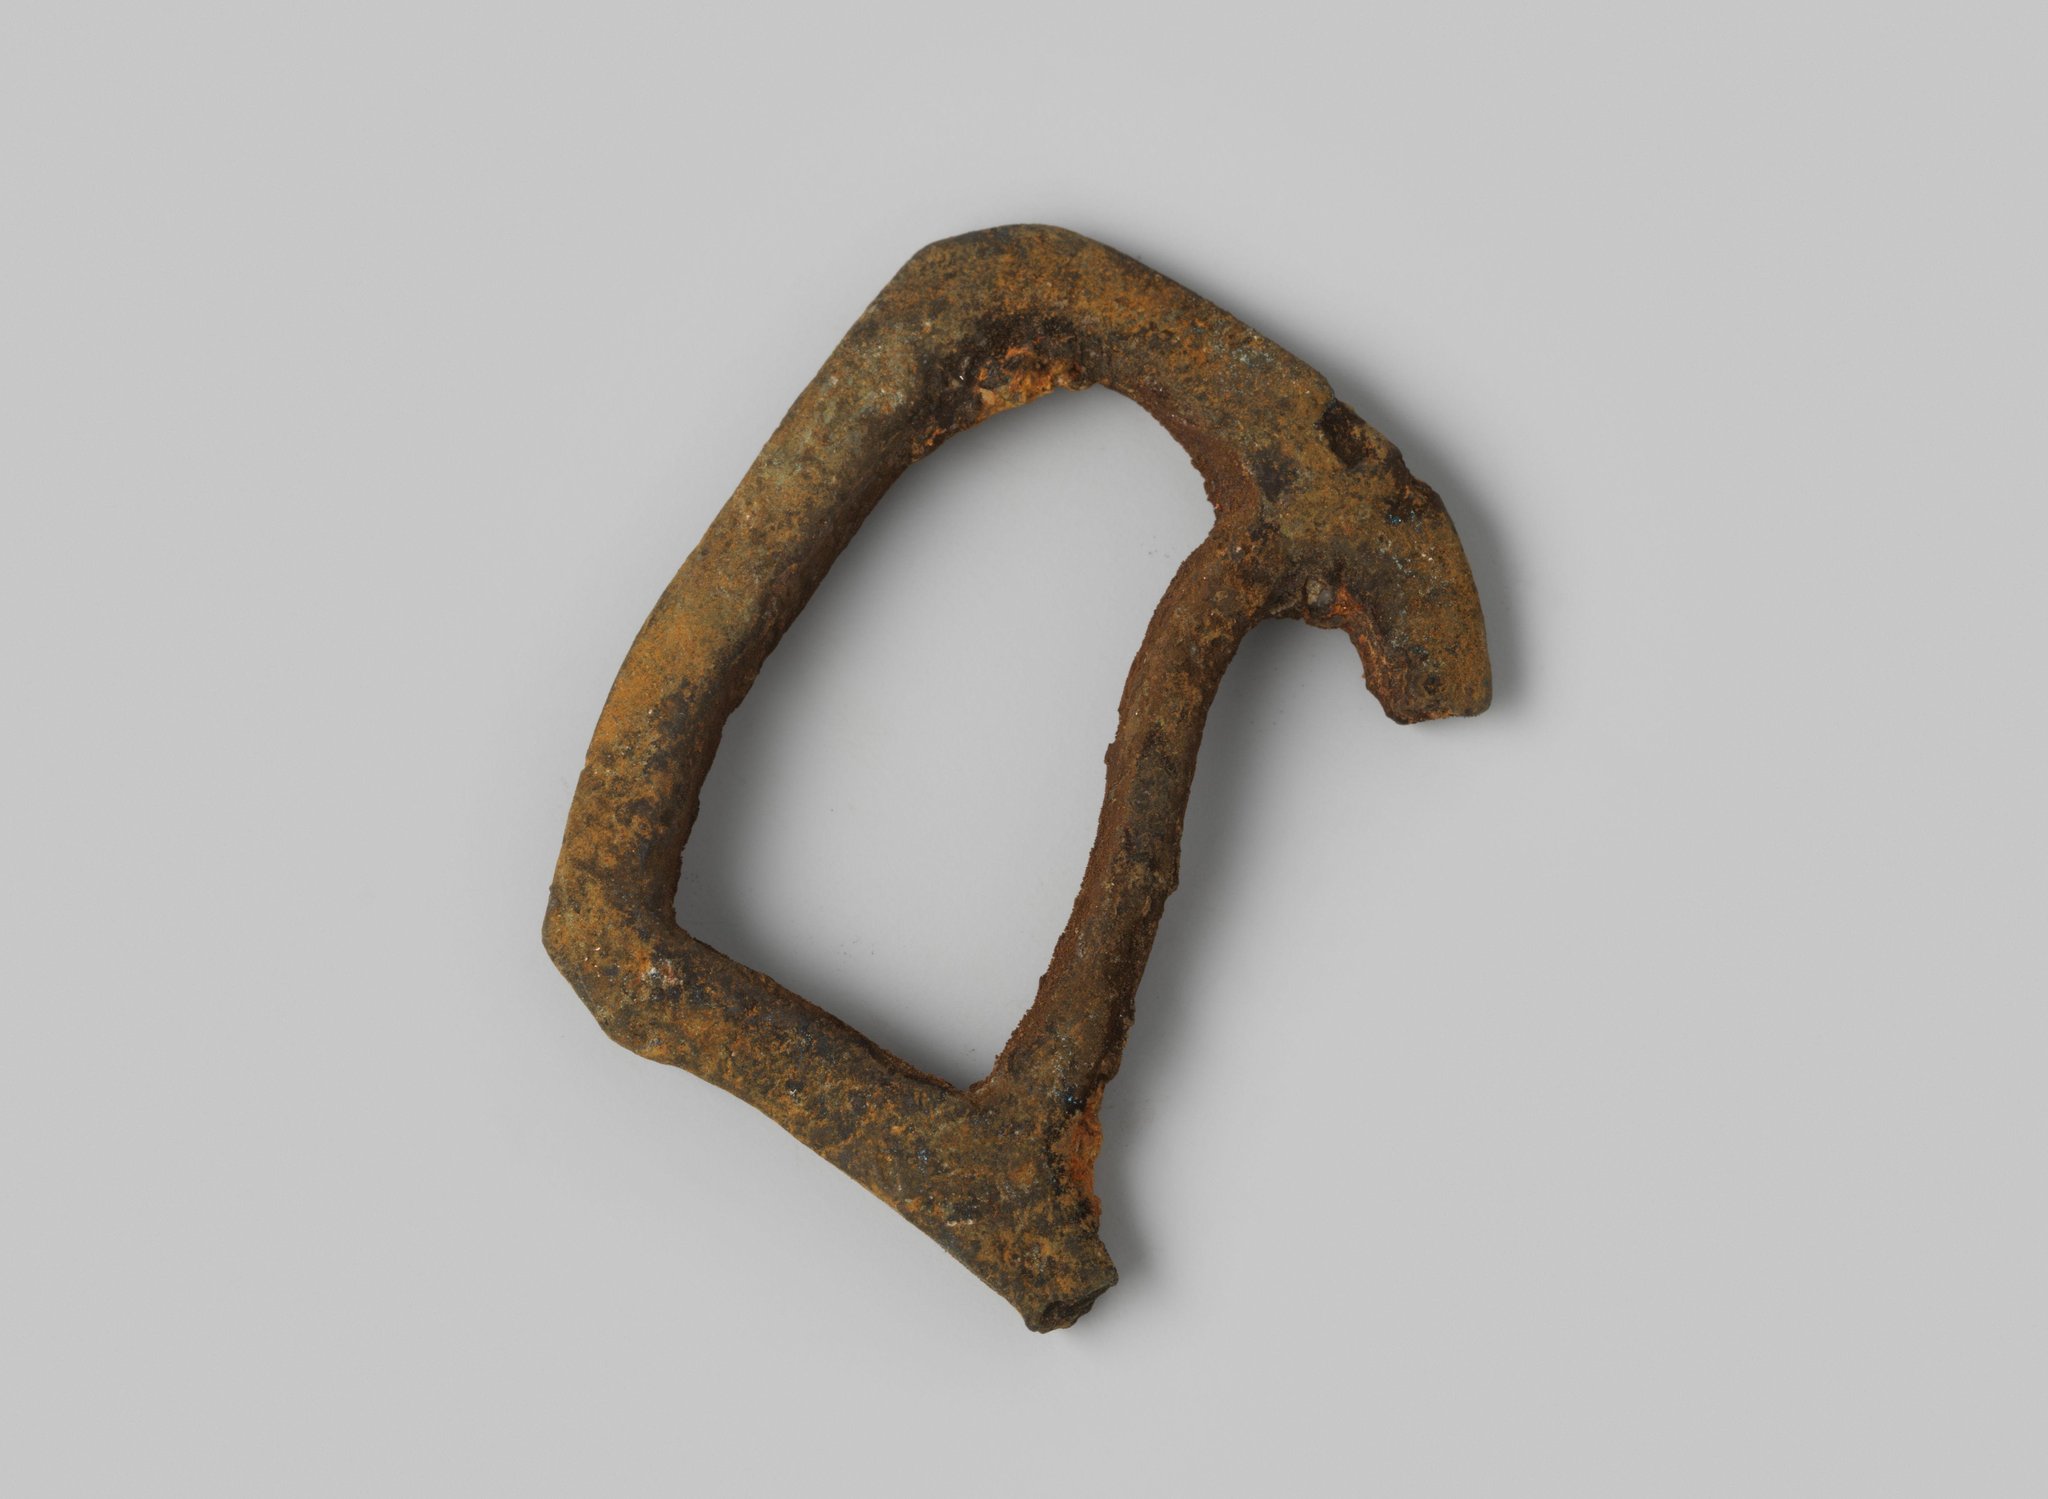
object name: belt buckle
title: Fragment riemgesp uit het wrak van de Oost-Indiëvaarder Hollandia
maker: Anonymous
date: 1700-1743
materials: stone, copper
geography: netherlands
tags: verenigde oostindische compagnie, hollandia (schip), annet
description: D-shaped with pointed side, fragm of ring-spindle, id. NG 1980-27H384, belt buckle.